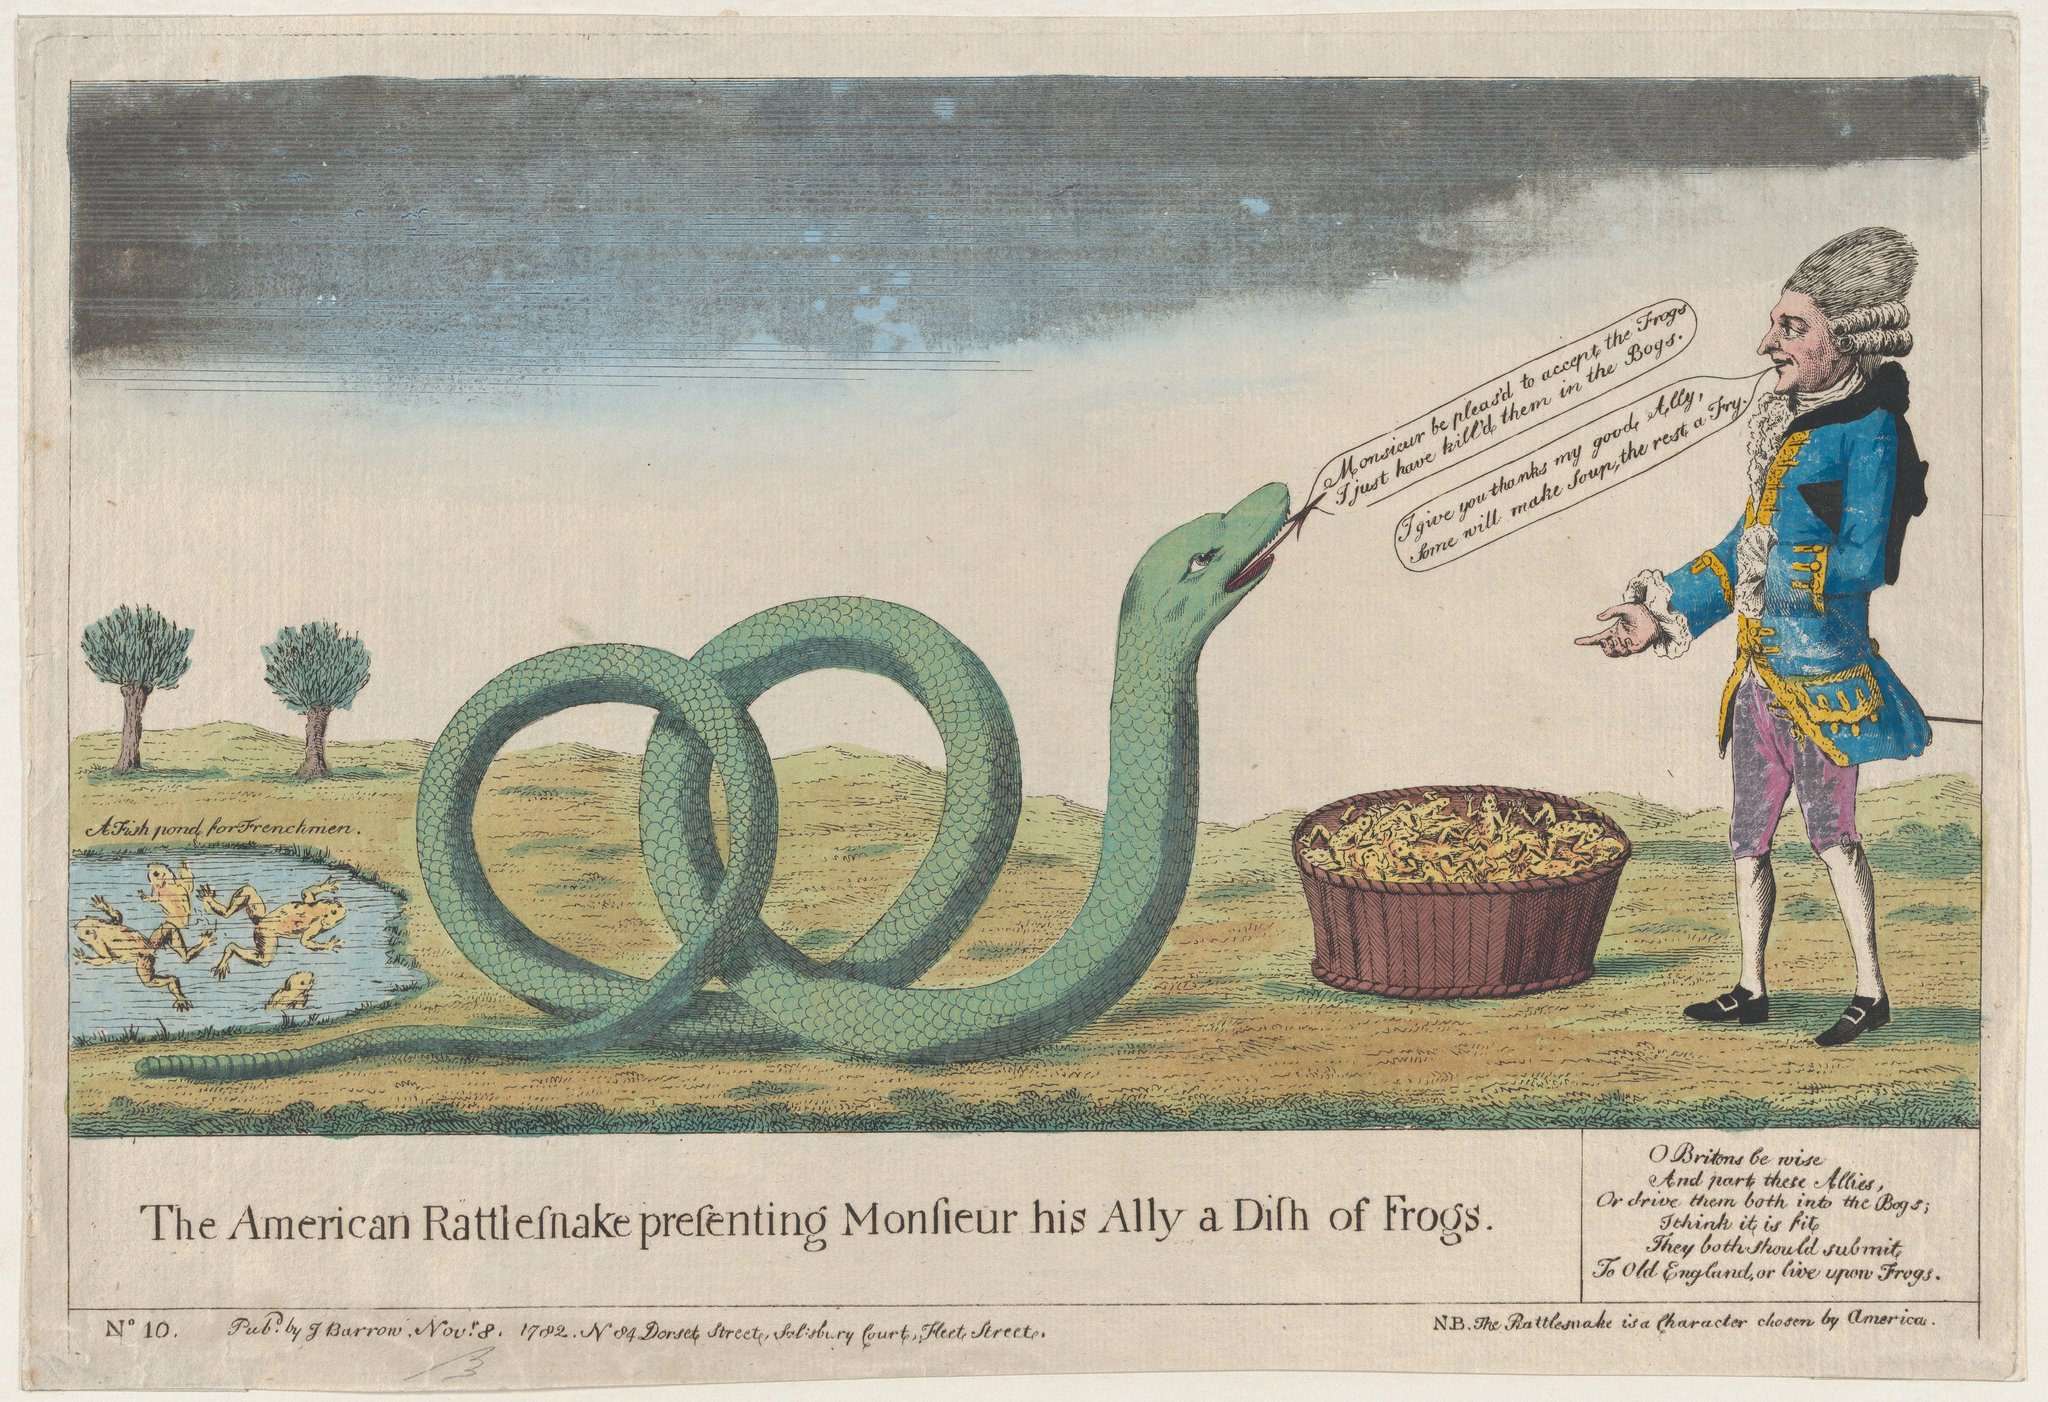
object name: print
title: The American Rattlesnake Presenting Monsieur his Ally [sic] a Dish of Frogs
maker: j. barrow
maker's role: publisher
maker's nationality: british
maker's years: 1730-1830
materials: watercolor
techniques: etching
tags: satire,american revolution,men,frogs,snakes,politics